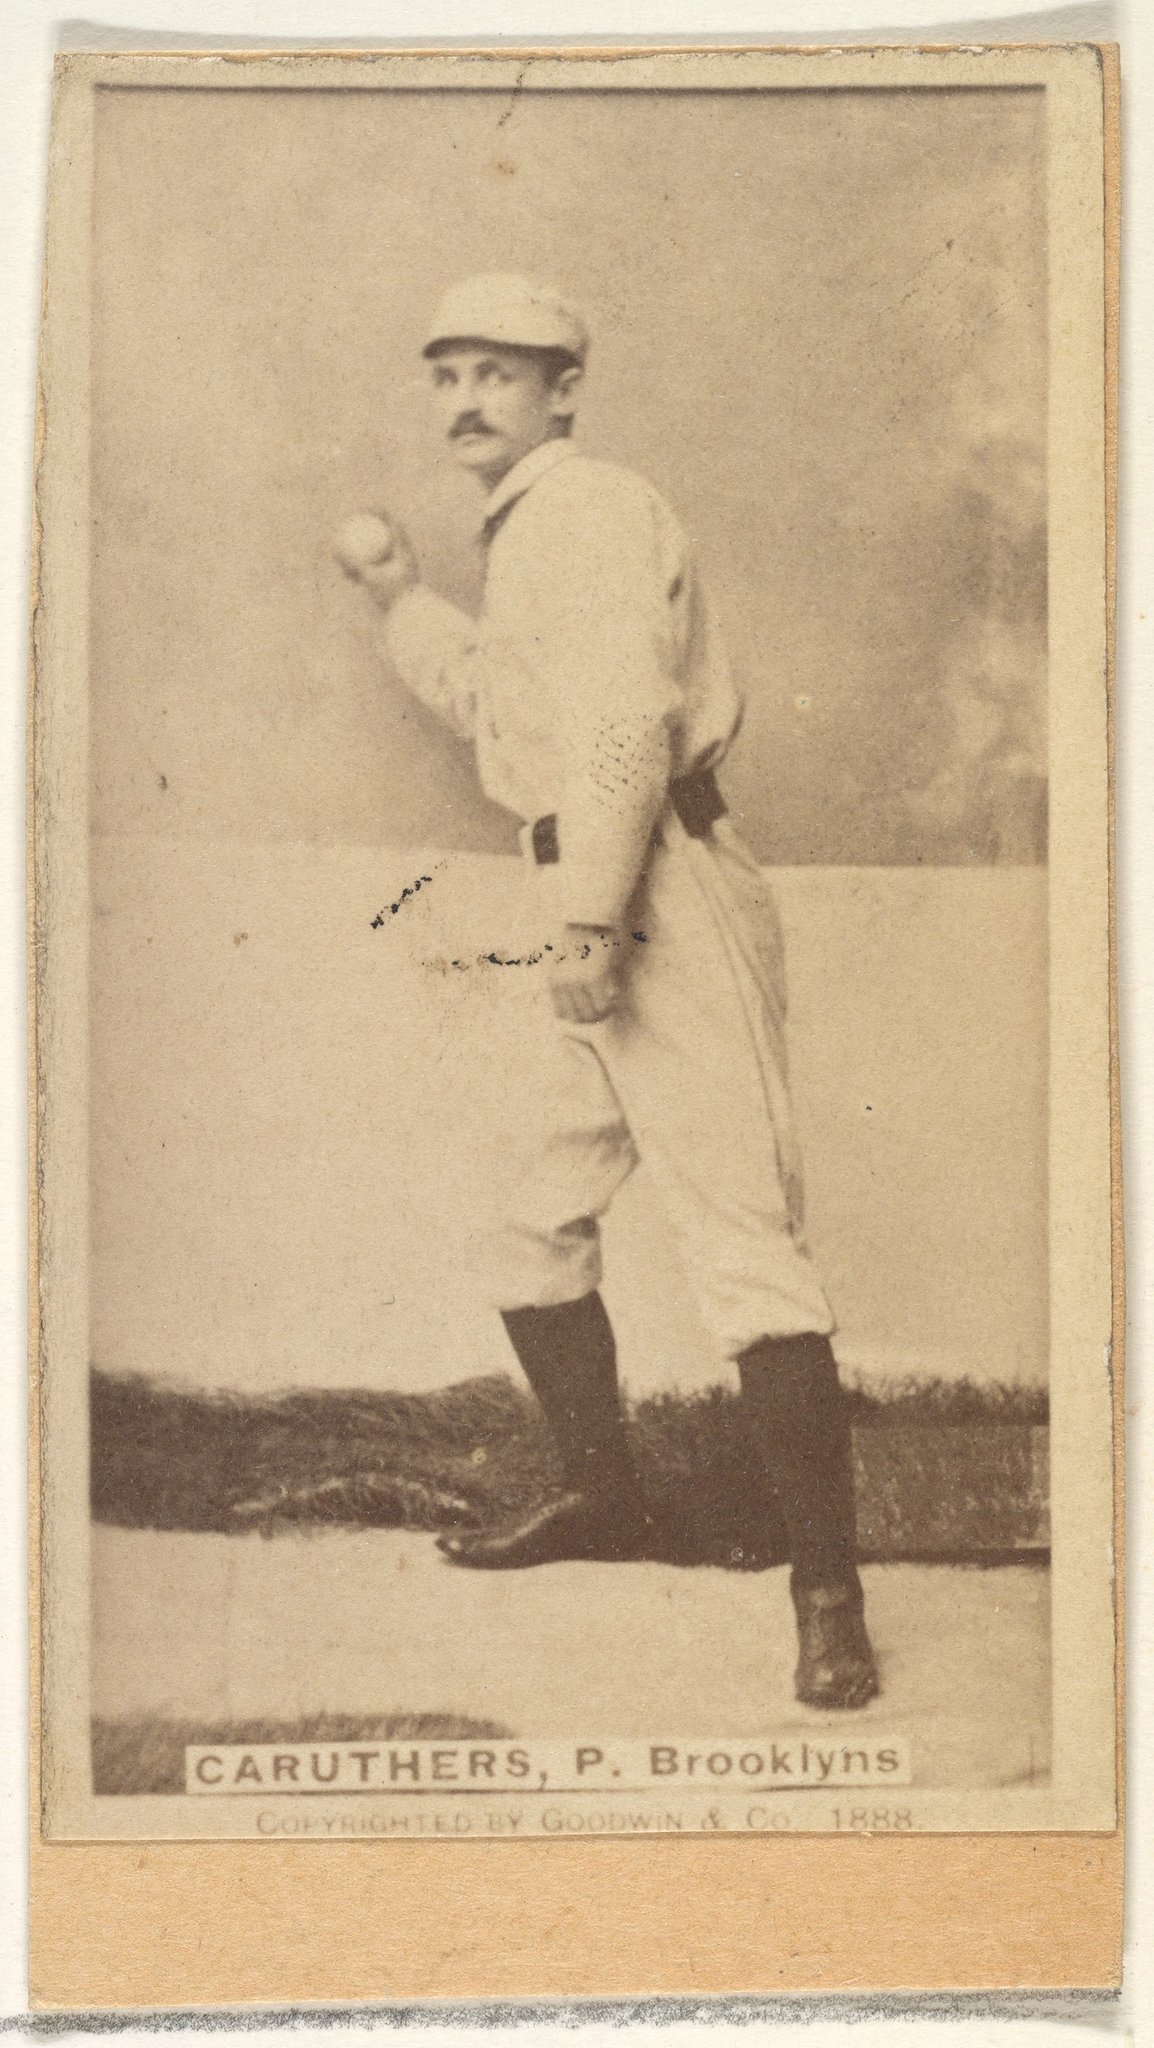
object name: baseball card, photograph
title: Caruthers, Pitcher, Brooklyn, from the Old Judge series (N172) for Old Judge Cigarettes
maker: goodwin & company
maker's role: publisher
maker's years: 1850-1950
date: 1888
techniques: albumen silver print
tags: men,portraits,baseball,athletes